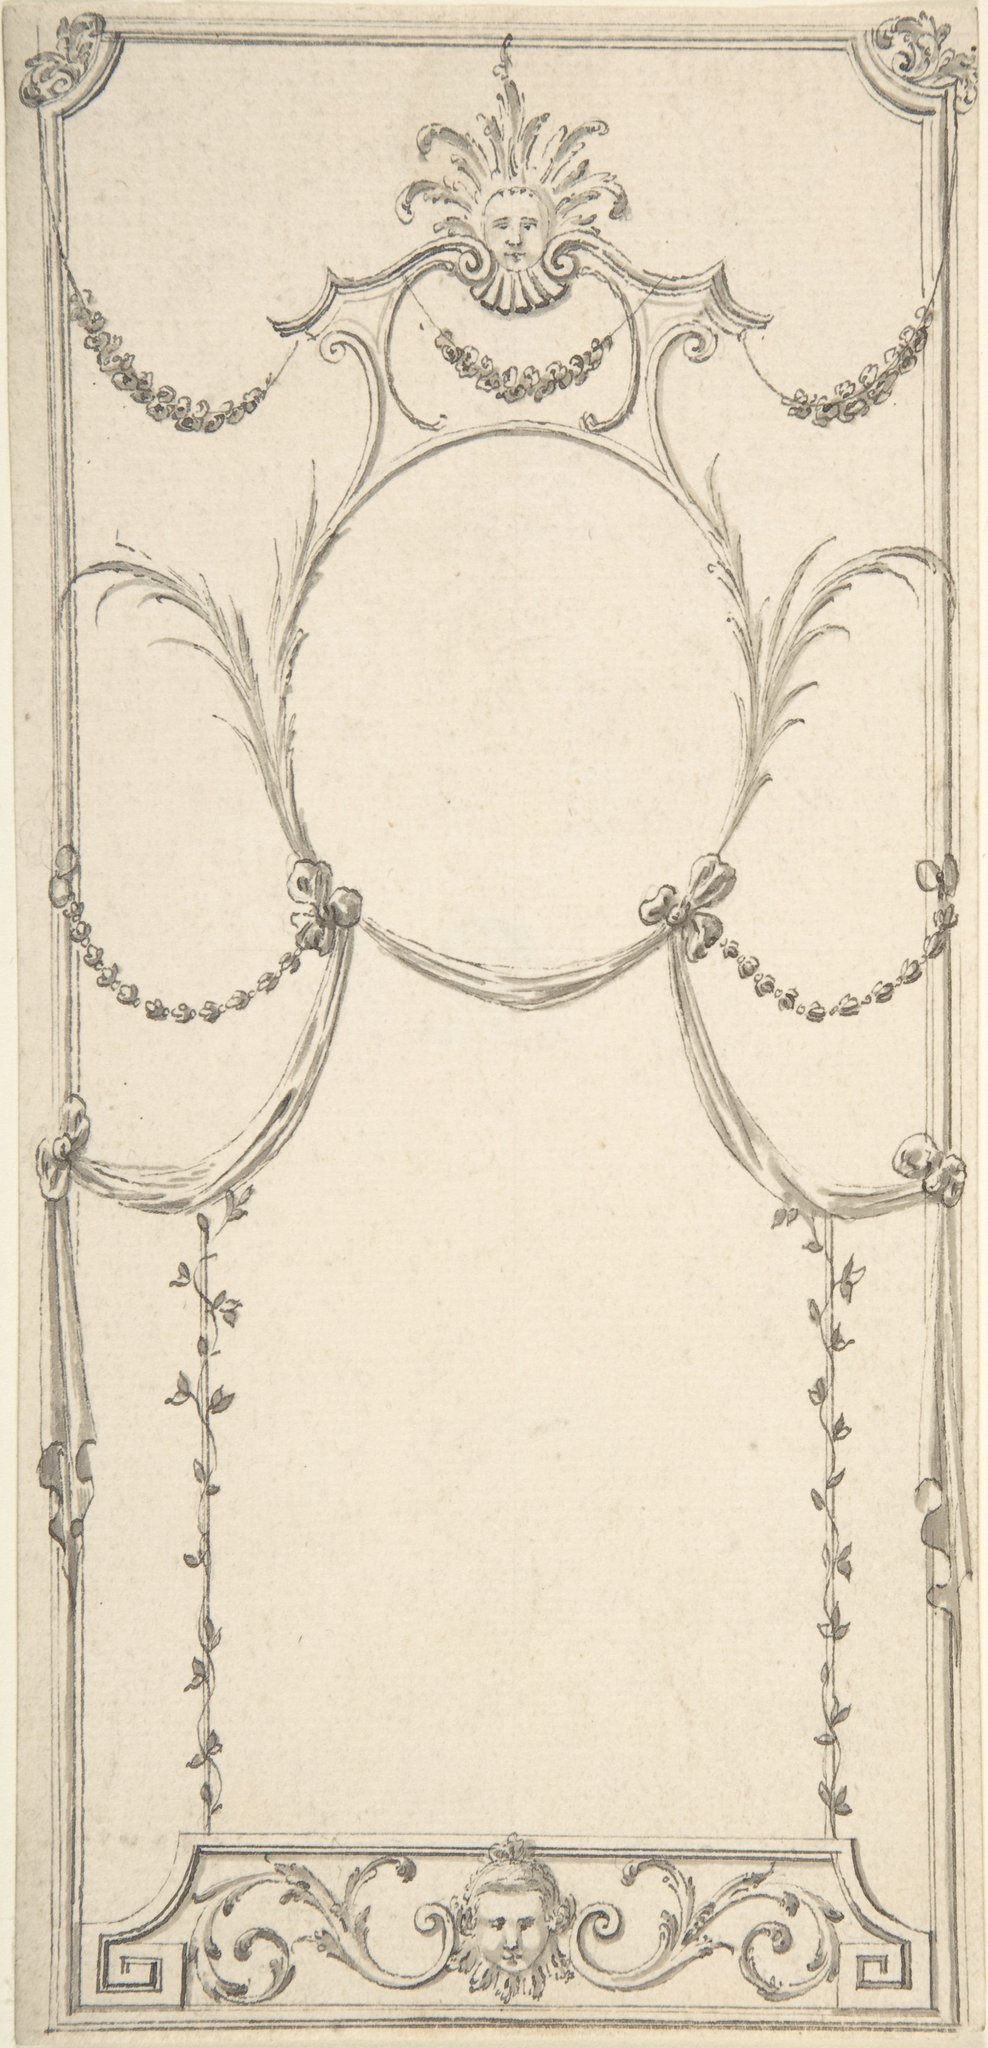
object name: drawing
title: Design for Wall Panel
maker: anonymous, british, 18th century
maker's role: artist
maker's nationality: british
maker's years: 1700-1800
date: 1734-1766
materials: ink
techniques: brush, pen, wash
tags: ornament